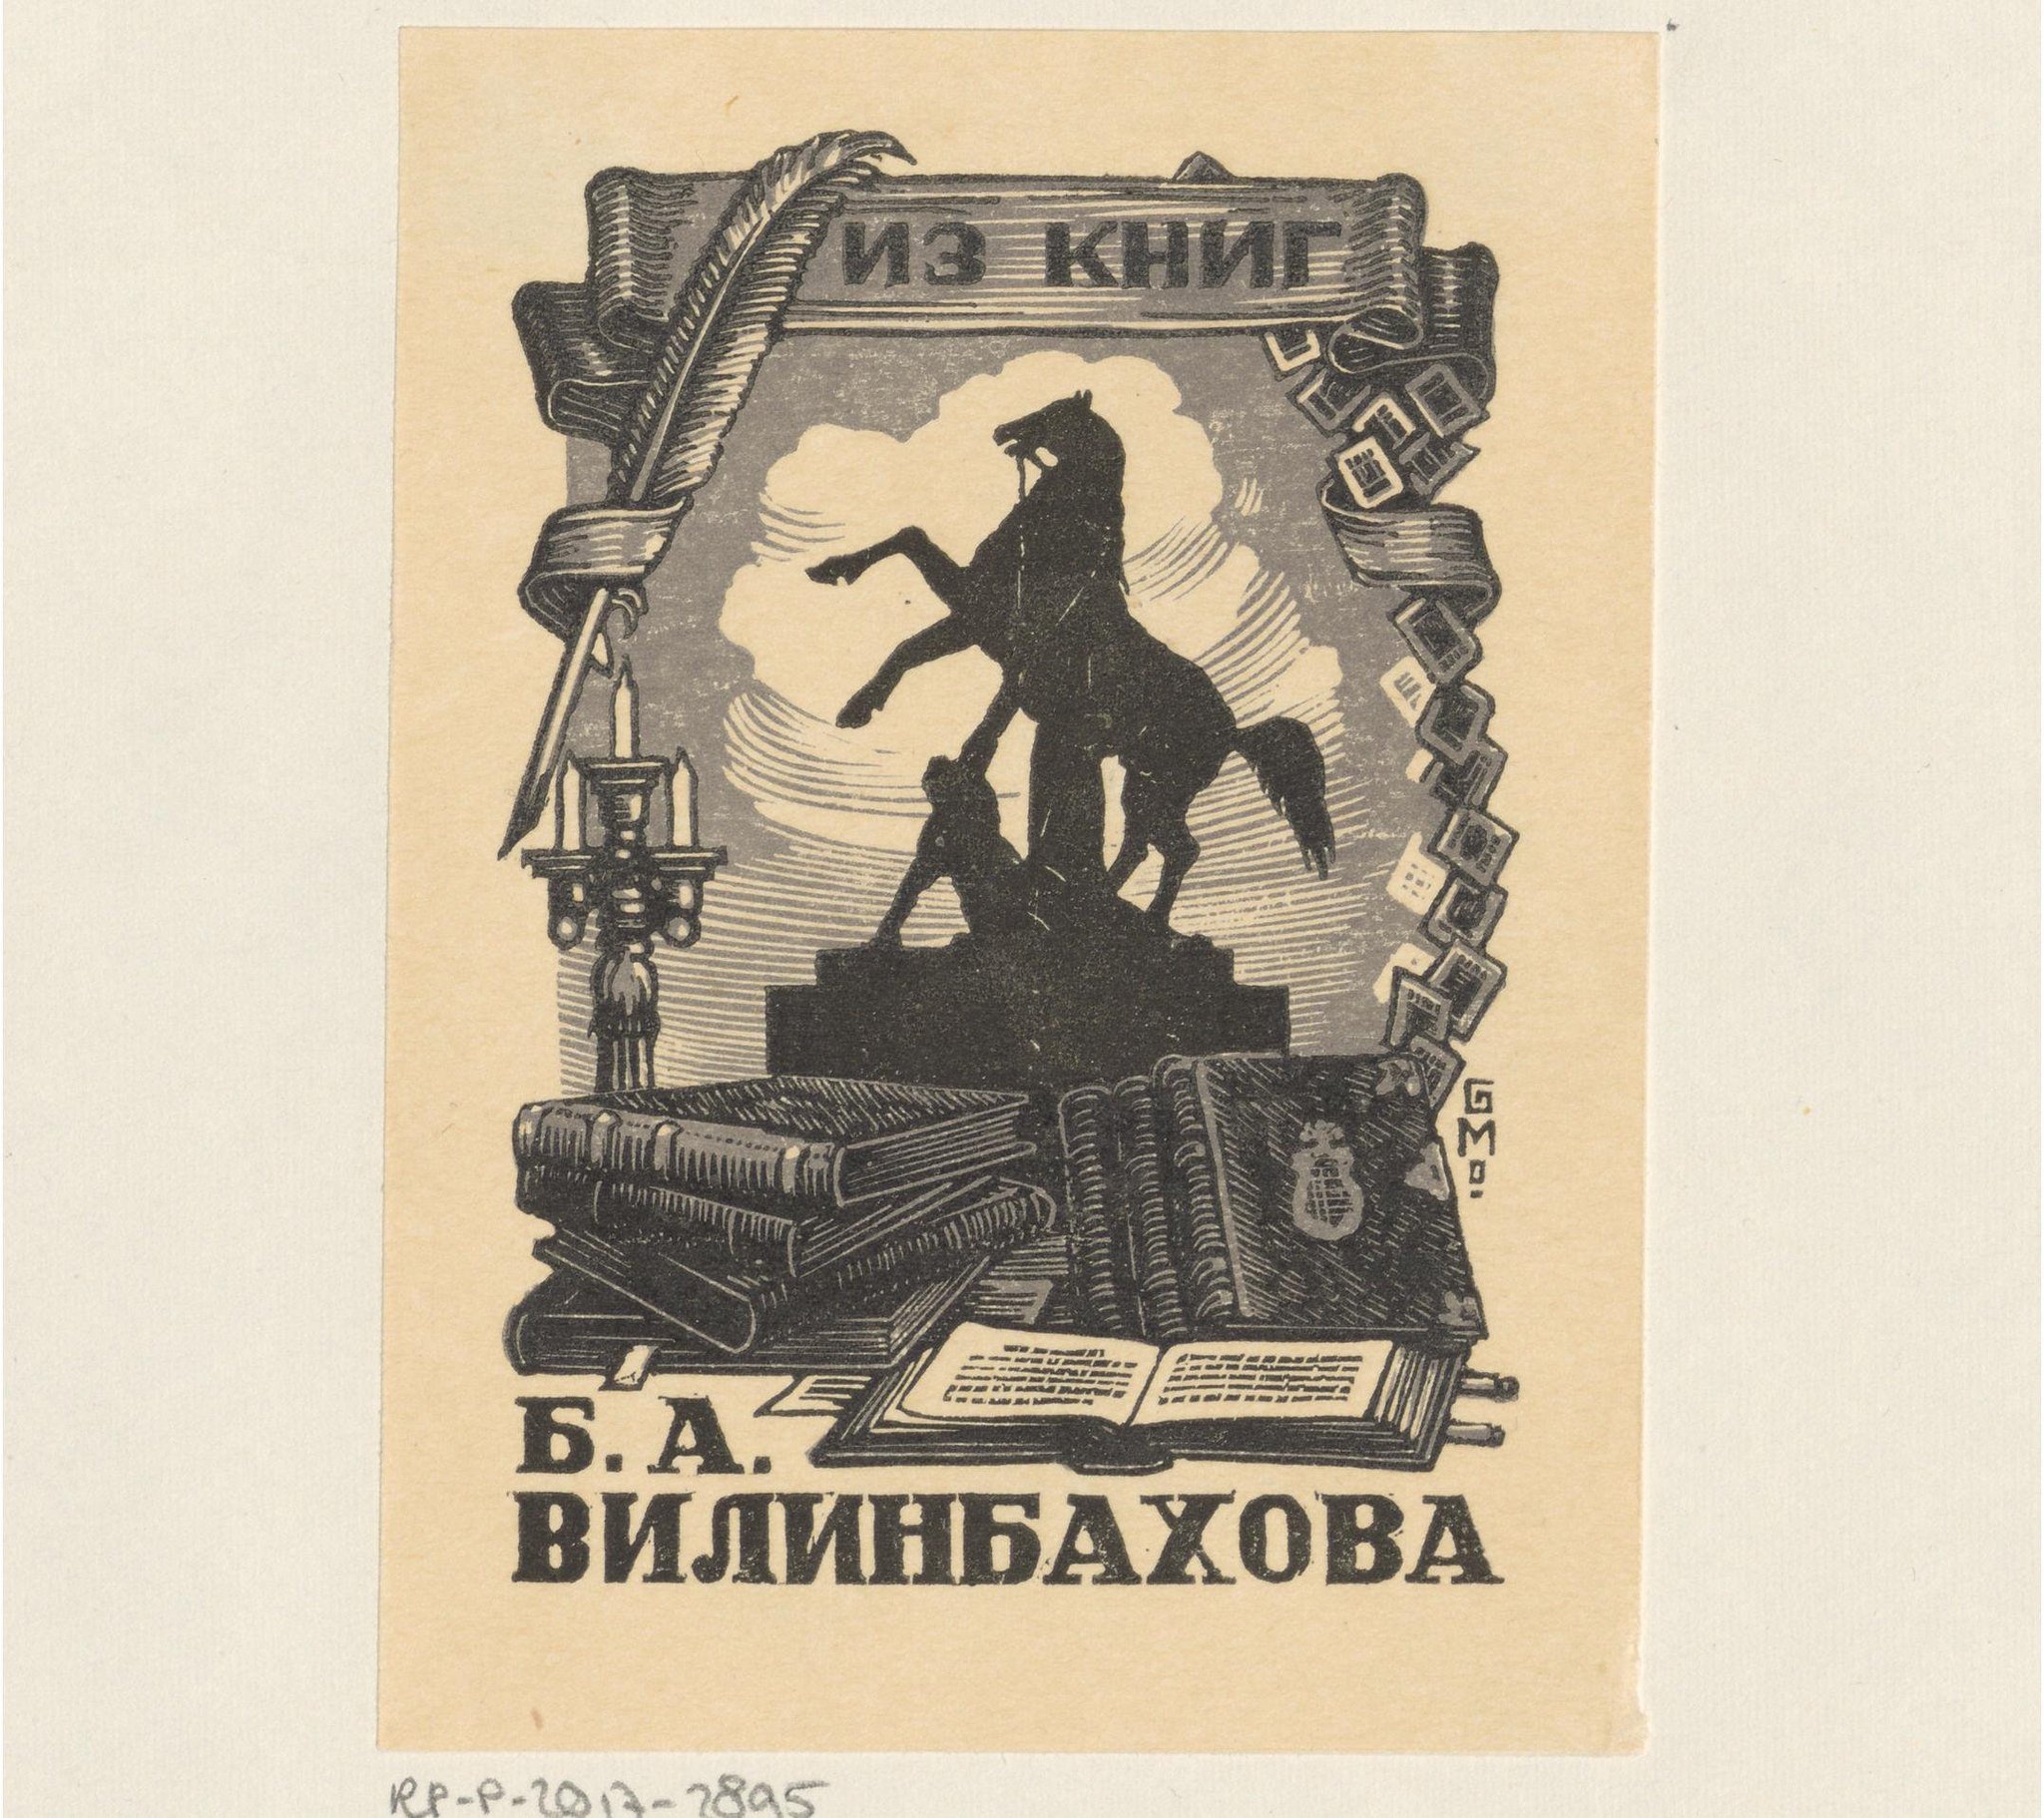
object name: bookplate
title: Ex libris van Б.А. Вилинбахова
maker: Anonymous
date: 1958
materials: paper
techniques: woodcut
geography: russia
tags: quill, ex-libris, book, monument, statue, horse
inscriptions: inscription: ‘Rumé / Sonykyer (?) / Moitse G 1958’